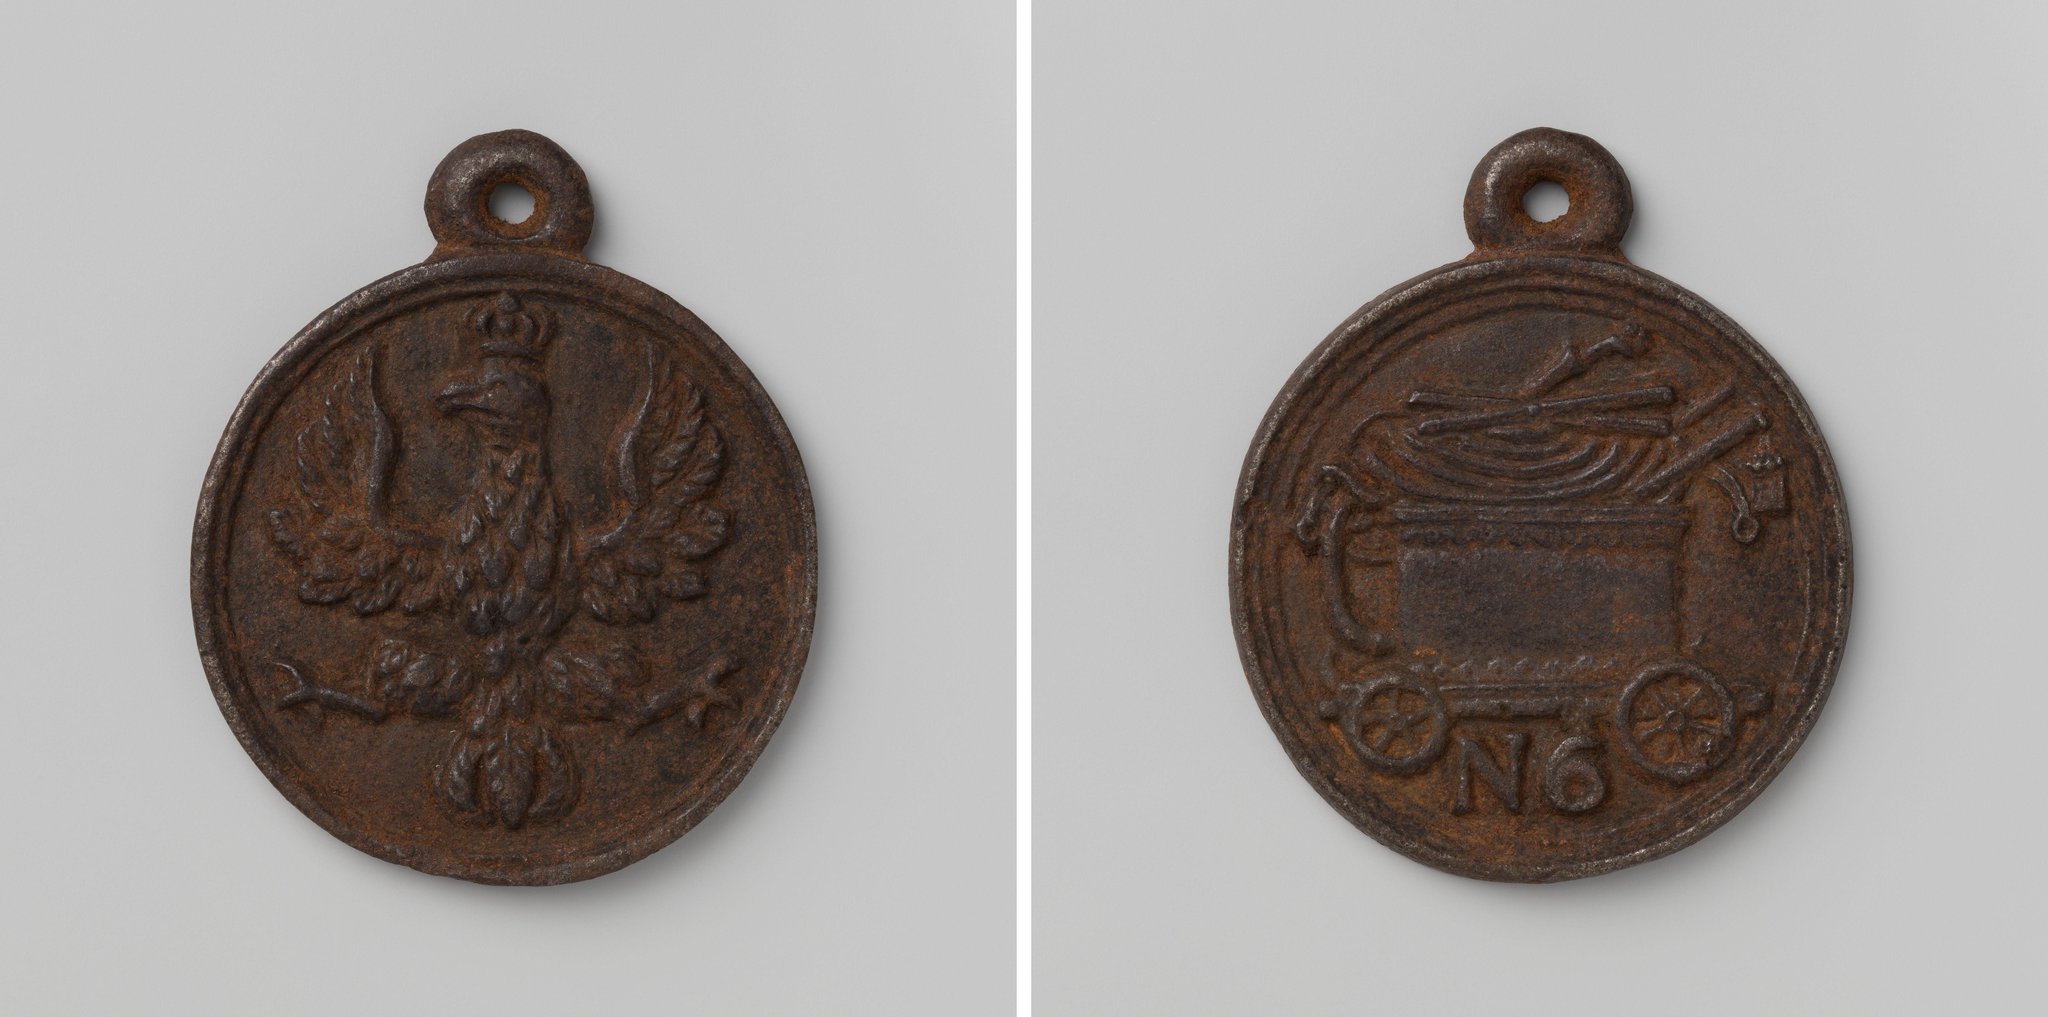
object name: medal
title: Deventer, brandspuitpenning met no. 6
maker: Anonymous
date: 1680-1800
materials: iron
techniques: casting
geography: deventer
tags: deventer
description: IJzeren penning aan draagoog. Voorzijde: gekroonde adelaar met gespreide vleugels. Keerzijde: rijdende brandspuit boven cijfer No. 6.